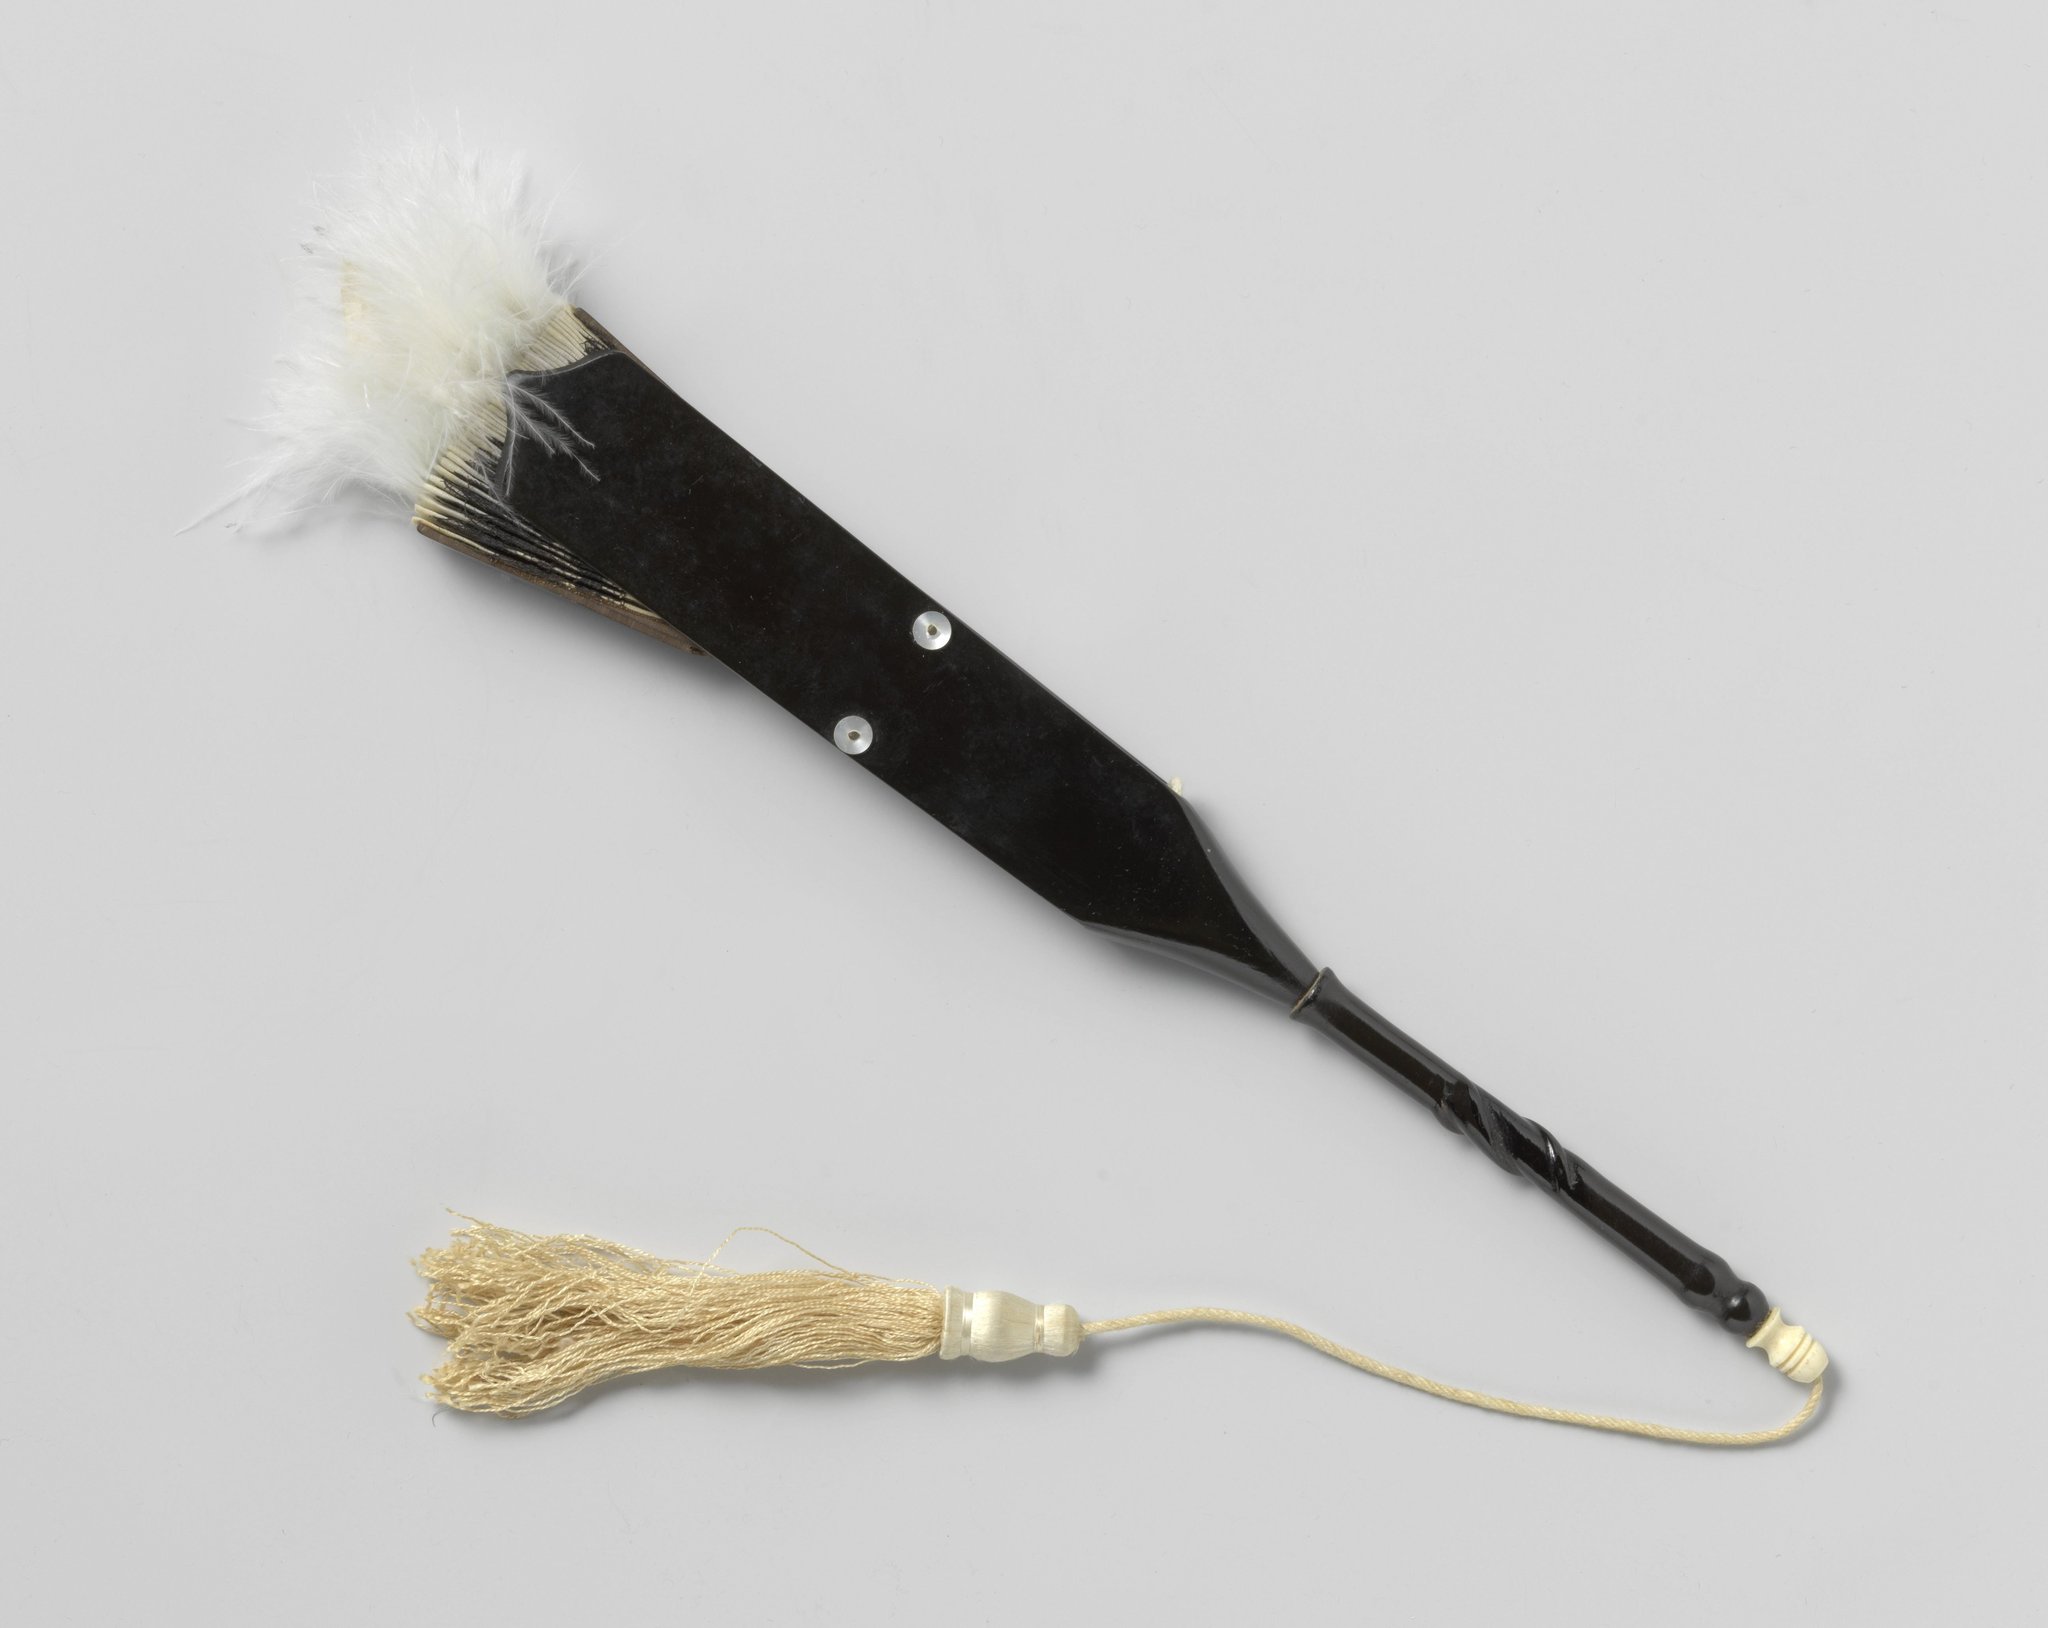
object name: cockade fan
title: Kokardewaaier met cirkelvormig blad van witte batist met zwarte kantstrook en witte maraboeveertjes aan de buitenrand, zwart gelakt houten montuur in houder, zijden kwast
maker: Anonymous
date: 1900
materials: textile, copper, feather, ivory, mother of pearl, silk, wood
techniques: cutting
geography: netherlands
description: Zwart gelakt houten montuur met ivoren knop en zijden kwast in houder met parelmoer schijfjes bij de sluitpinnen; cirkelvormig vouwblad van wit batist met zwarte kantstrook en witte maraboeveertjes aan de buitenrand.